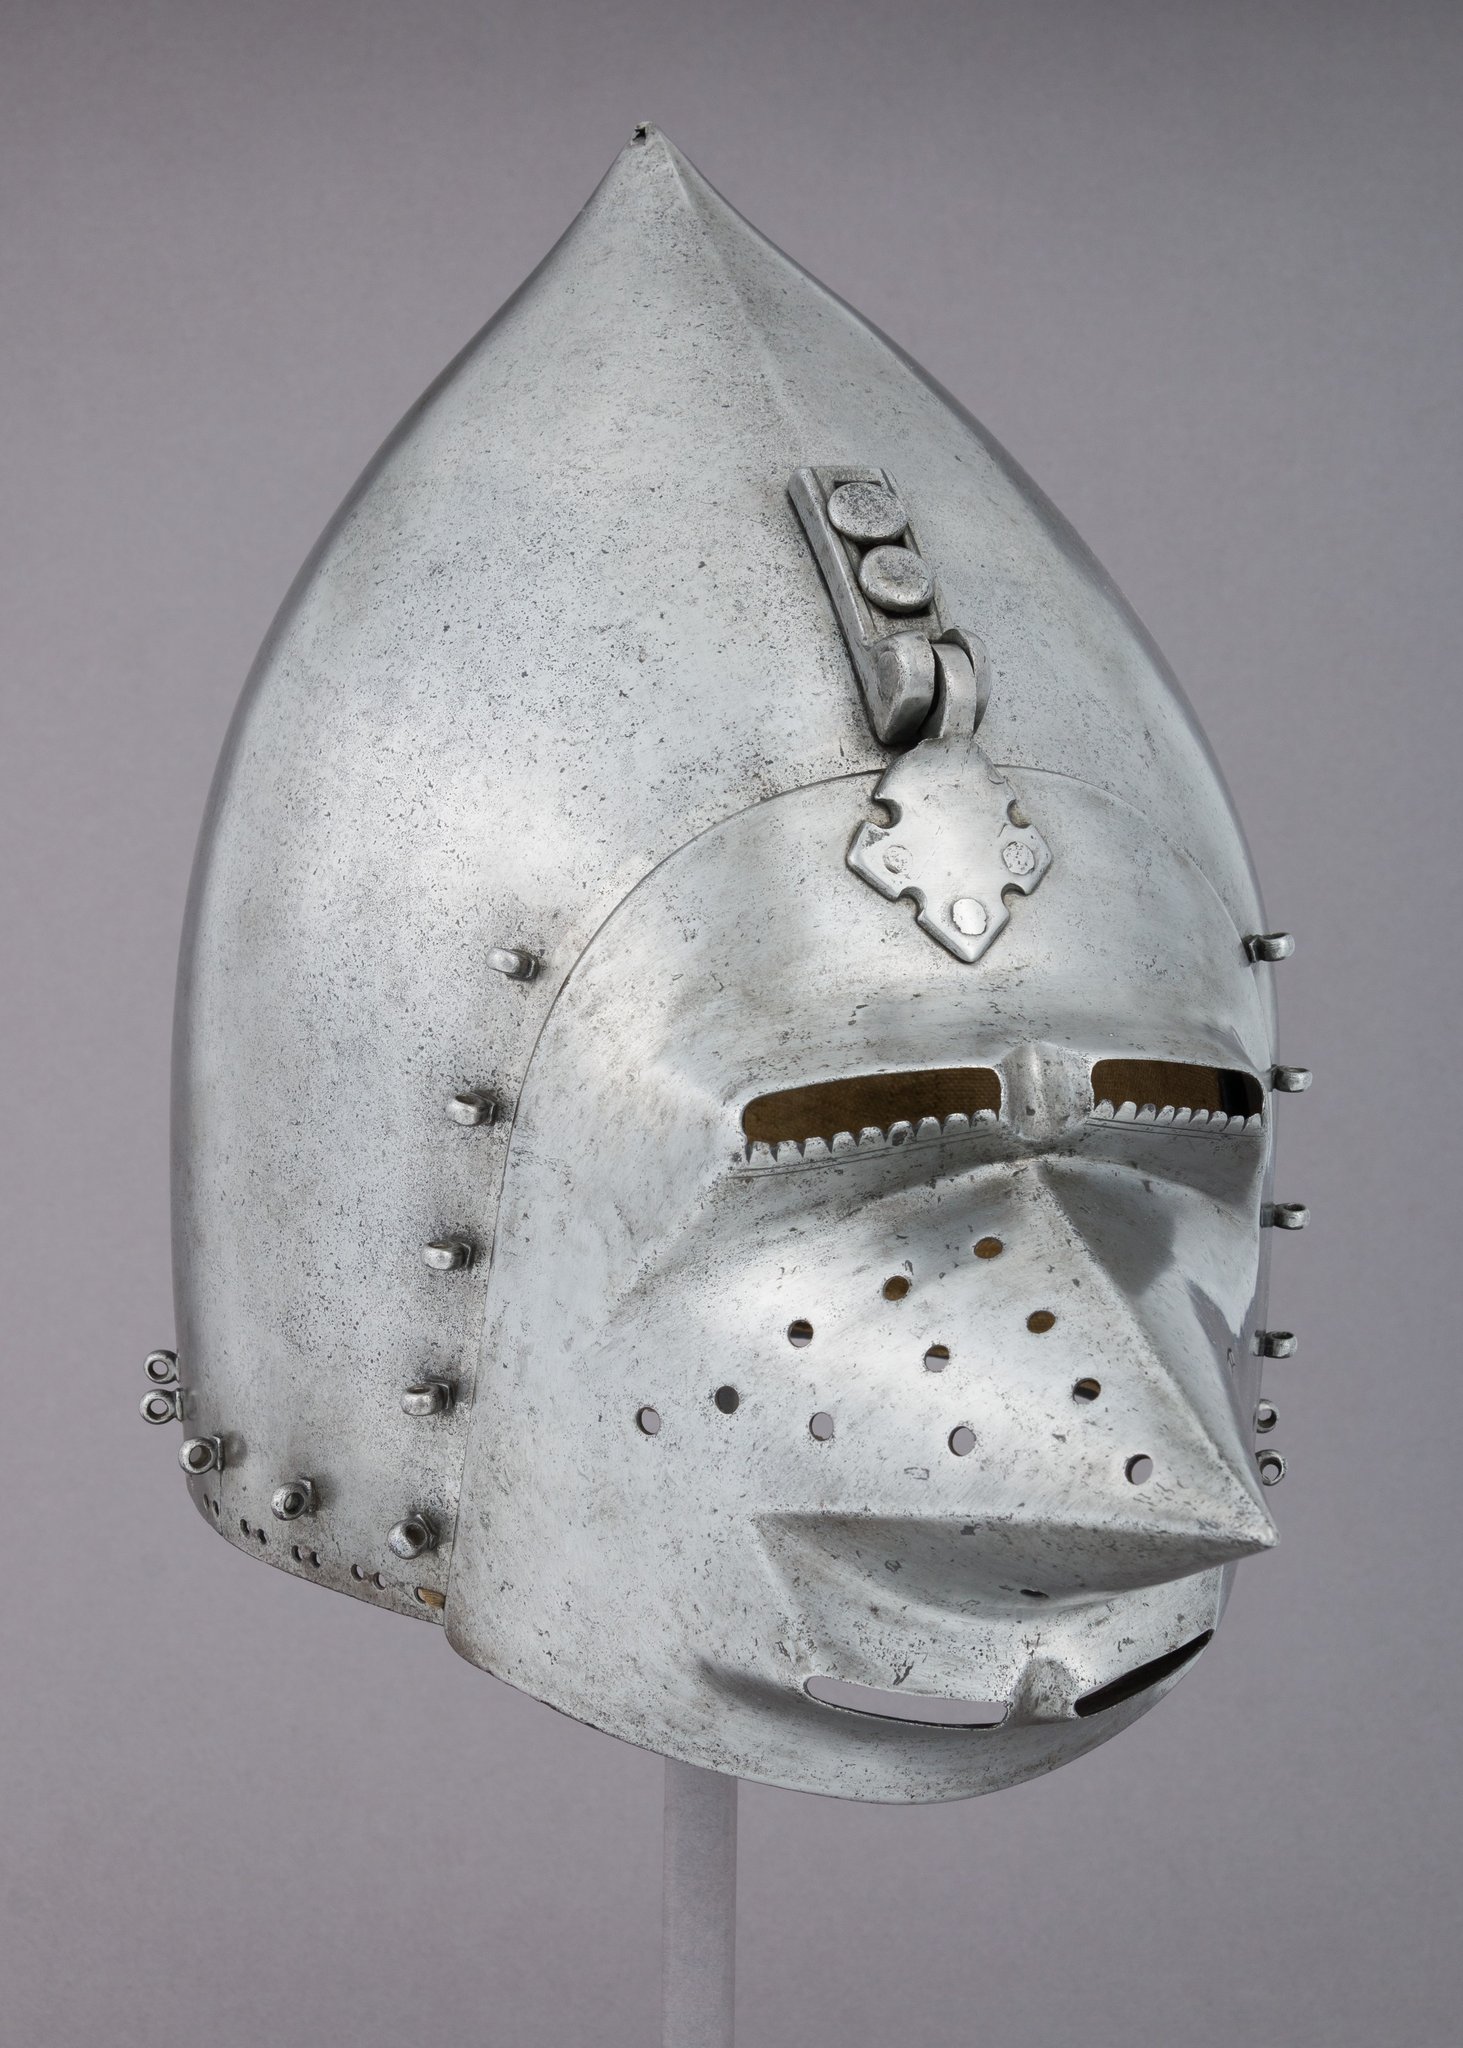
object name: bascinet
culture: german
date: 1801-1900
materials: steel, textile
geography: germany